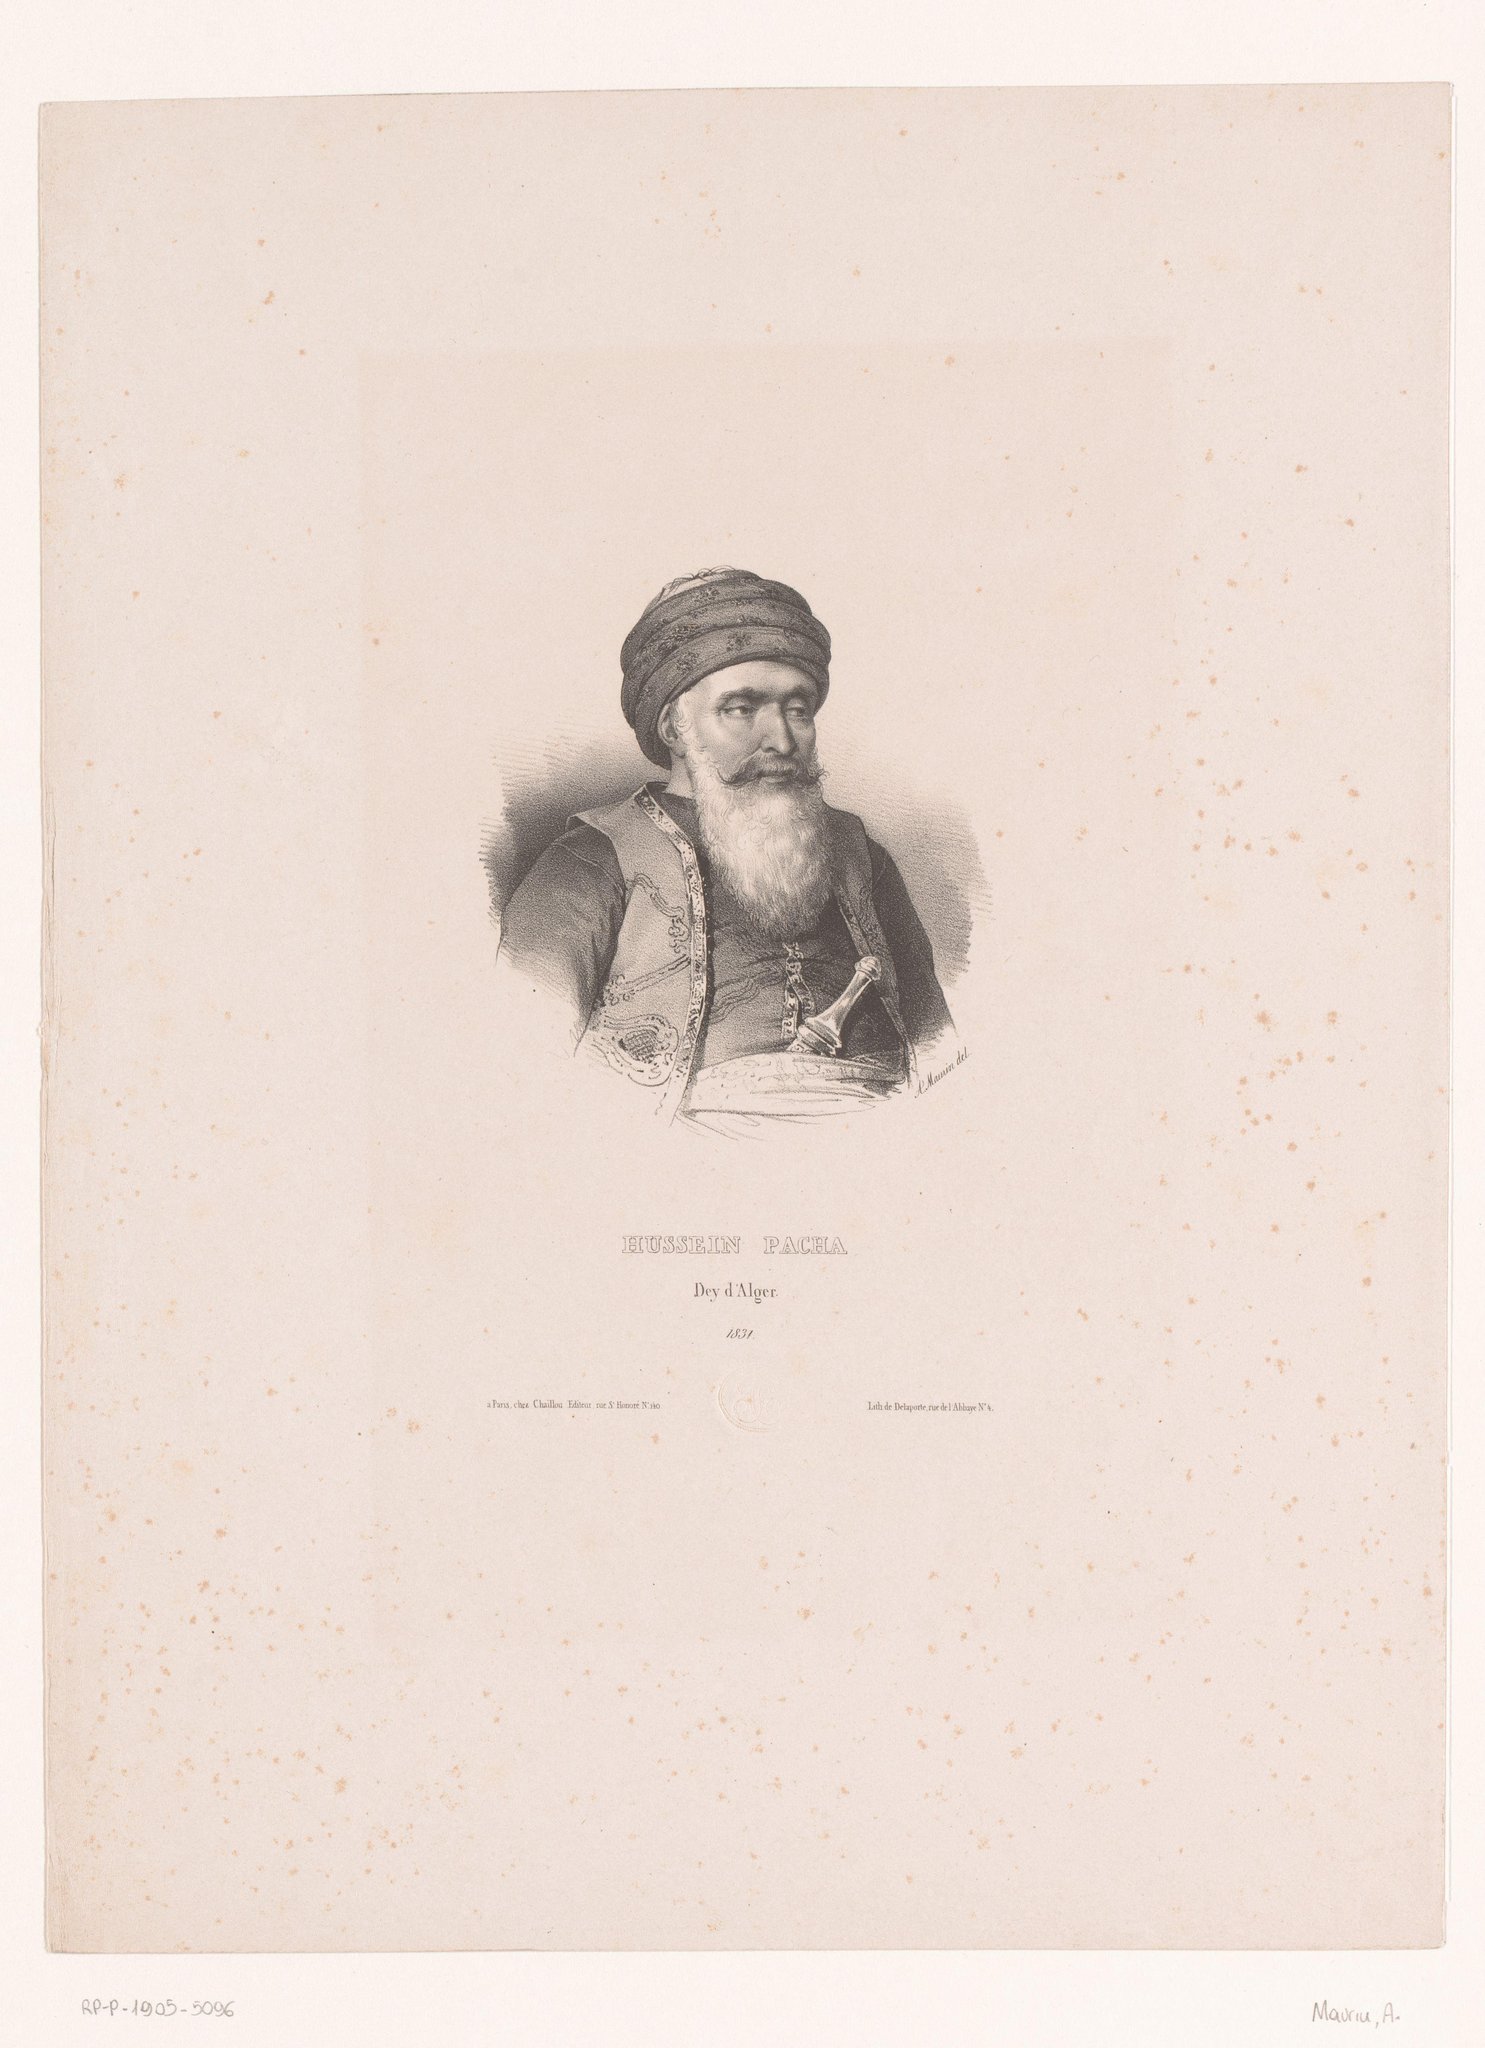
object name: print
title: Hussein Pacha, dey d'Alger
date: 1830-1832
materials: paper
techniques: lithograph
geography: paris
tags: historical persons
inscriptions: check stamp: Lugt 619, collector's mark: Lugt 2228